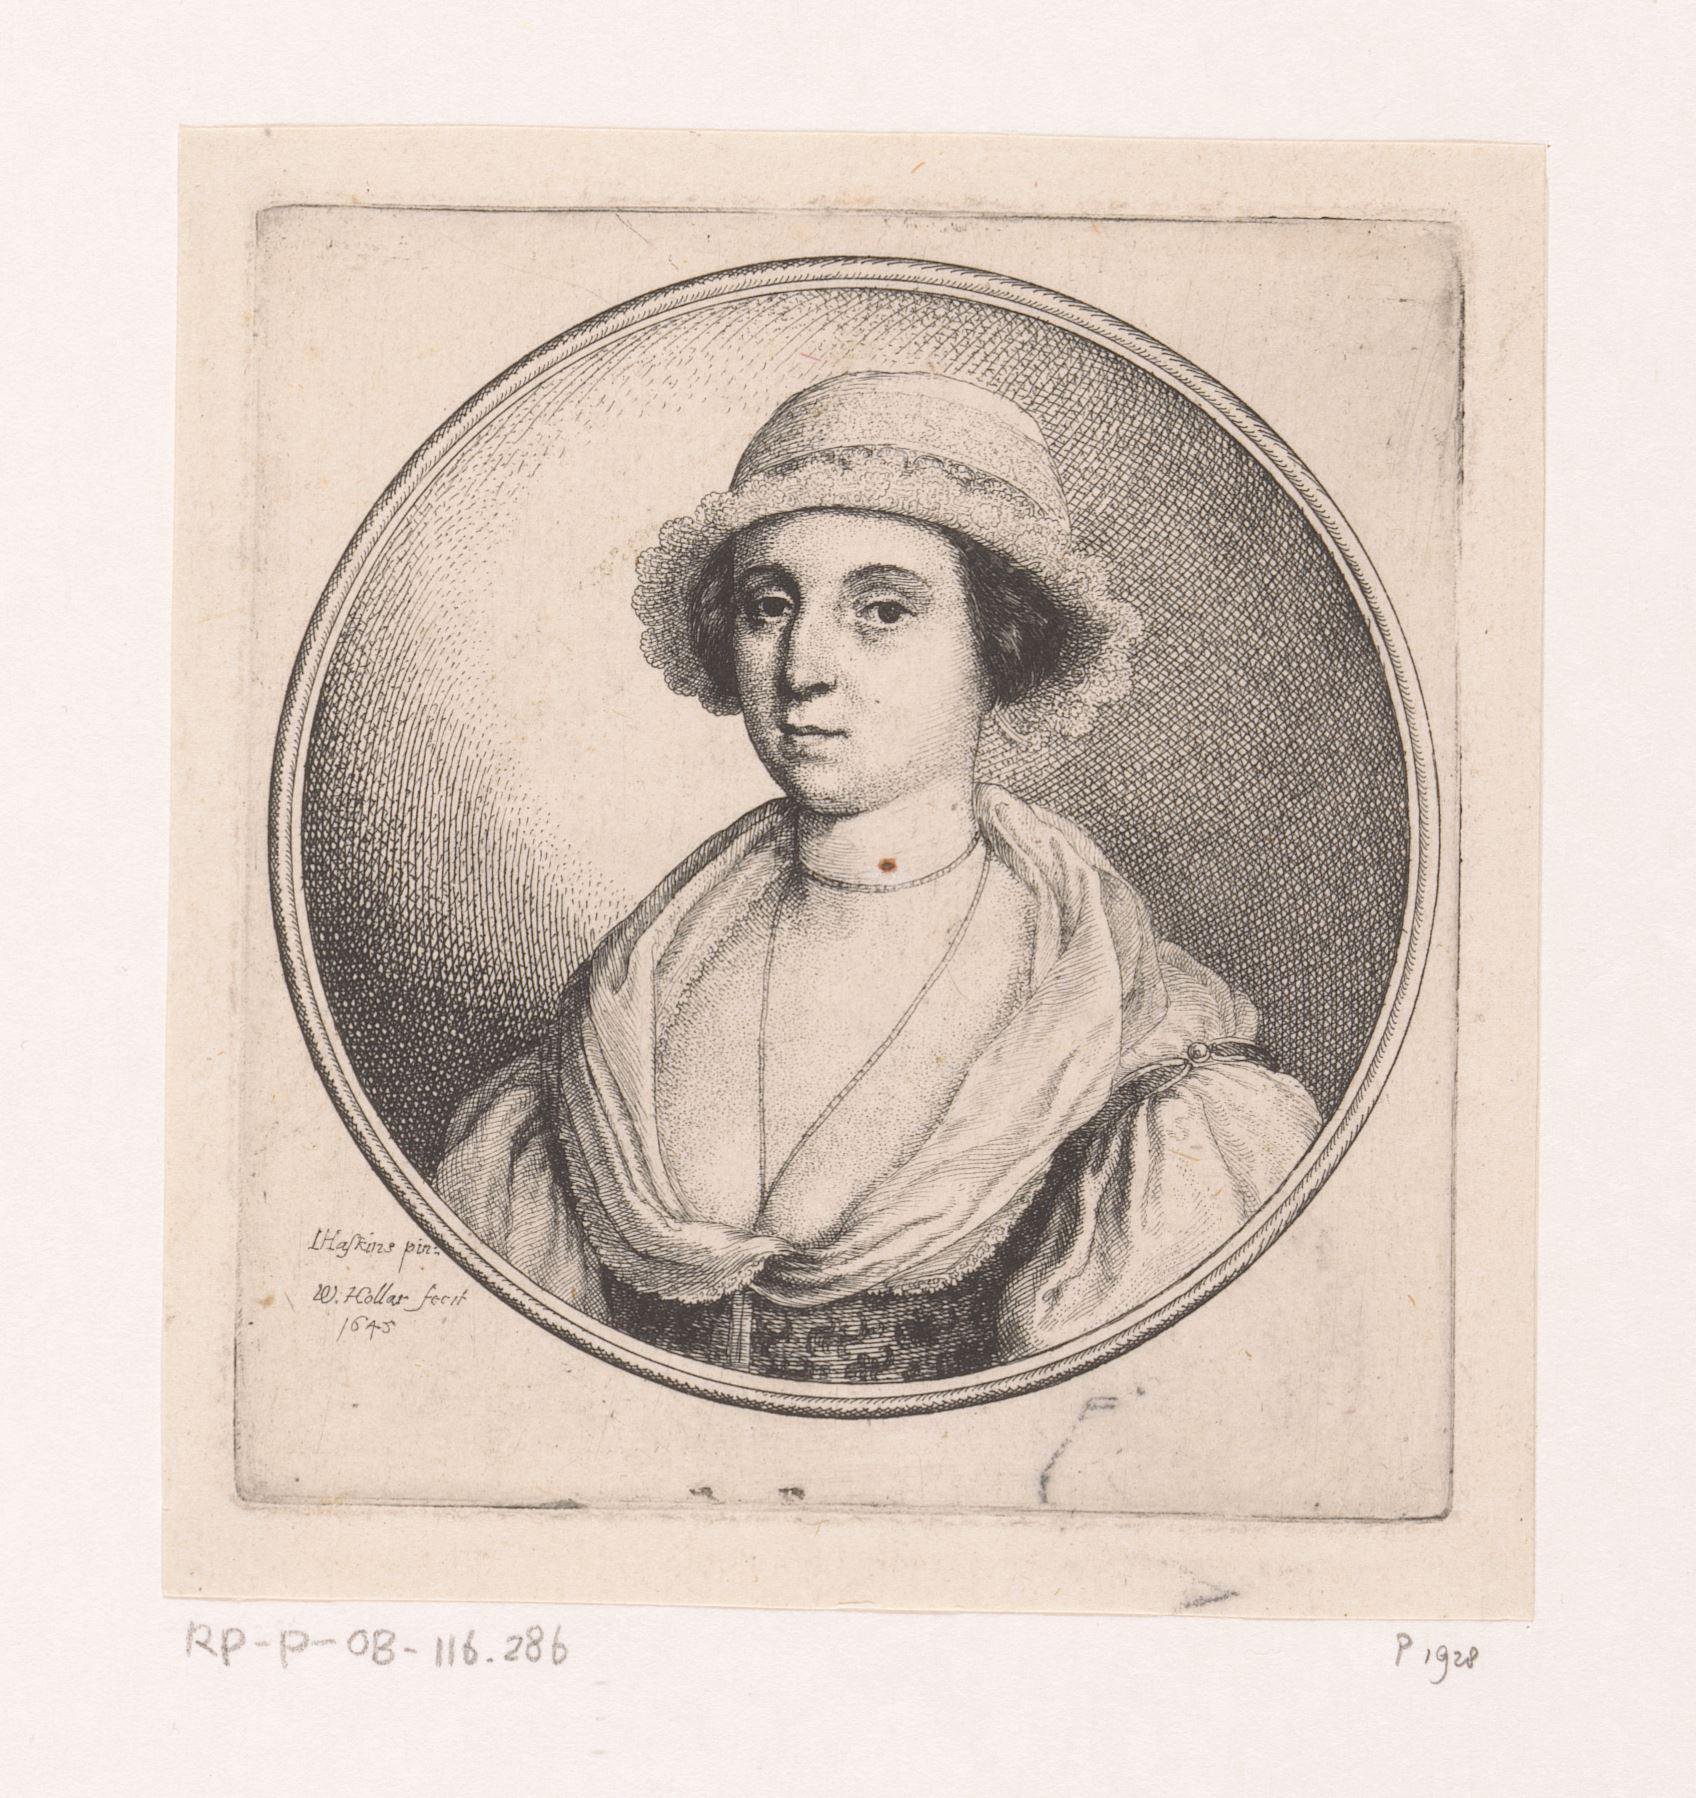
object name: costume print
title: Vrouwenbusten in ronde lijsten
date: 1645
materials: paper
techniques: etching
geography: london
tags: head-gear and clothing for the upper part of the body, ornament ~ medallion, styles of hairdress - aa - ~ women, head-gear: cap (+ women's clothes), fashion plates, lace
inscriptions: collector's mark: Lugt 240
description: Buste van vrouw met mutsje met kanten boord en een doek om haar schouders die in haar keurslijf is weggestopt.